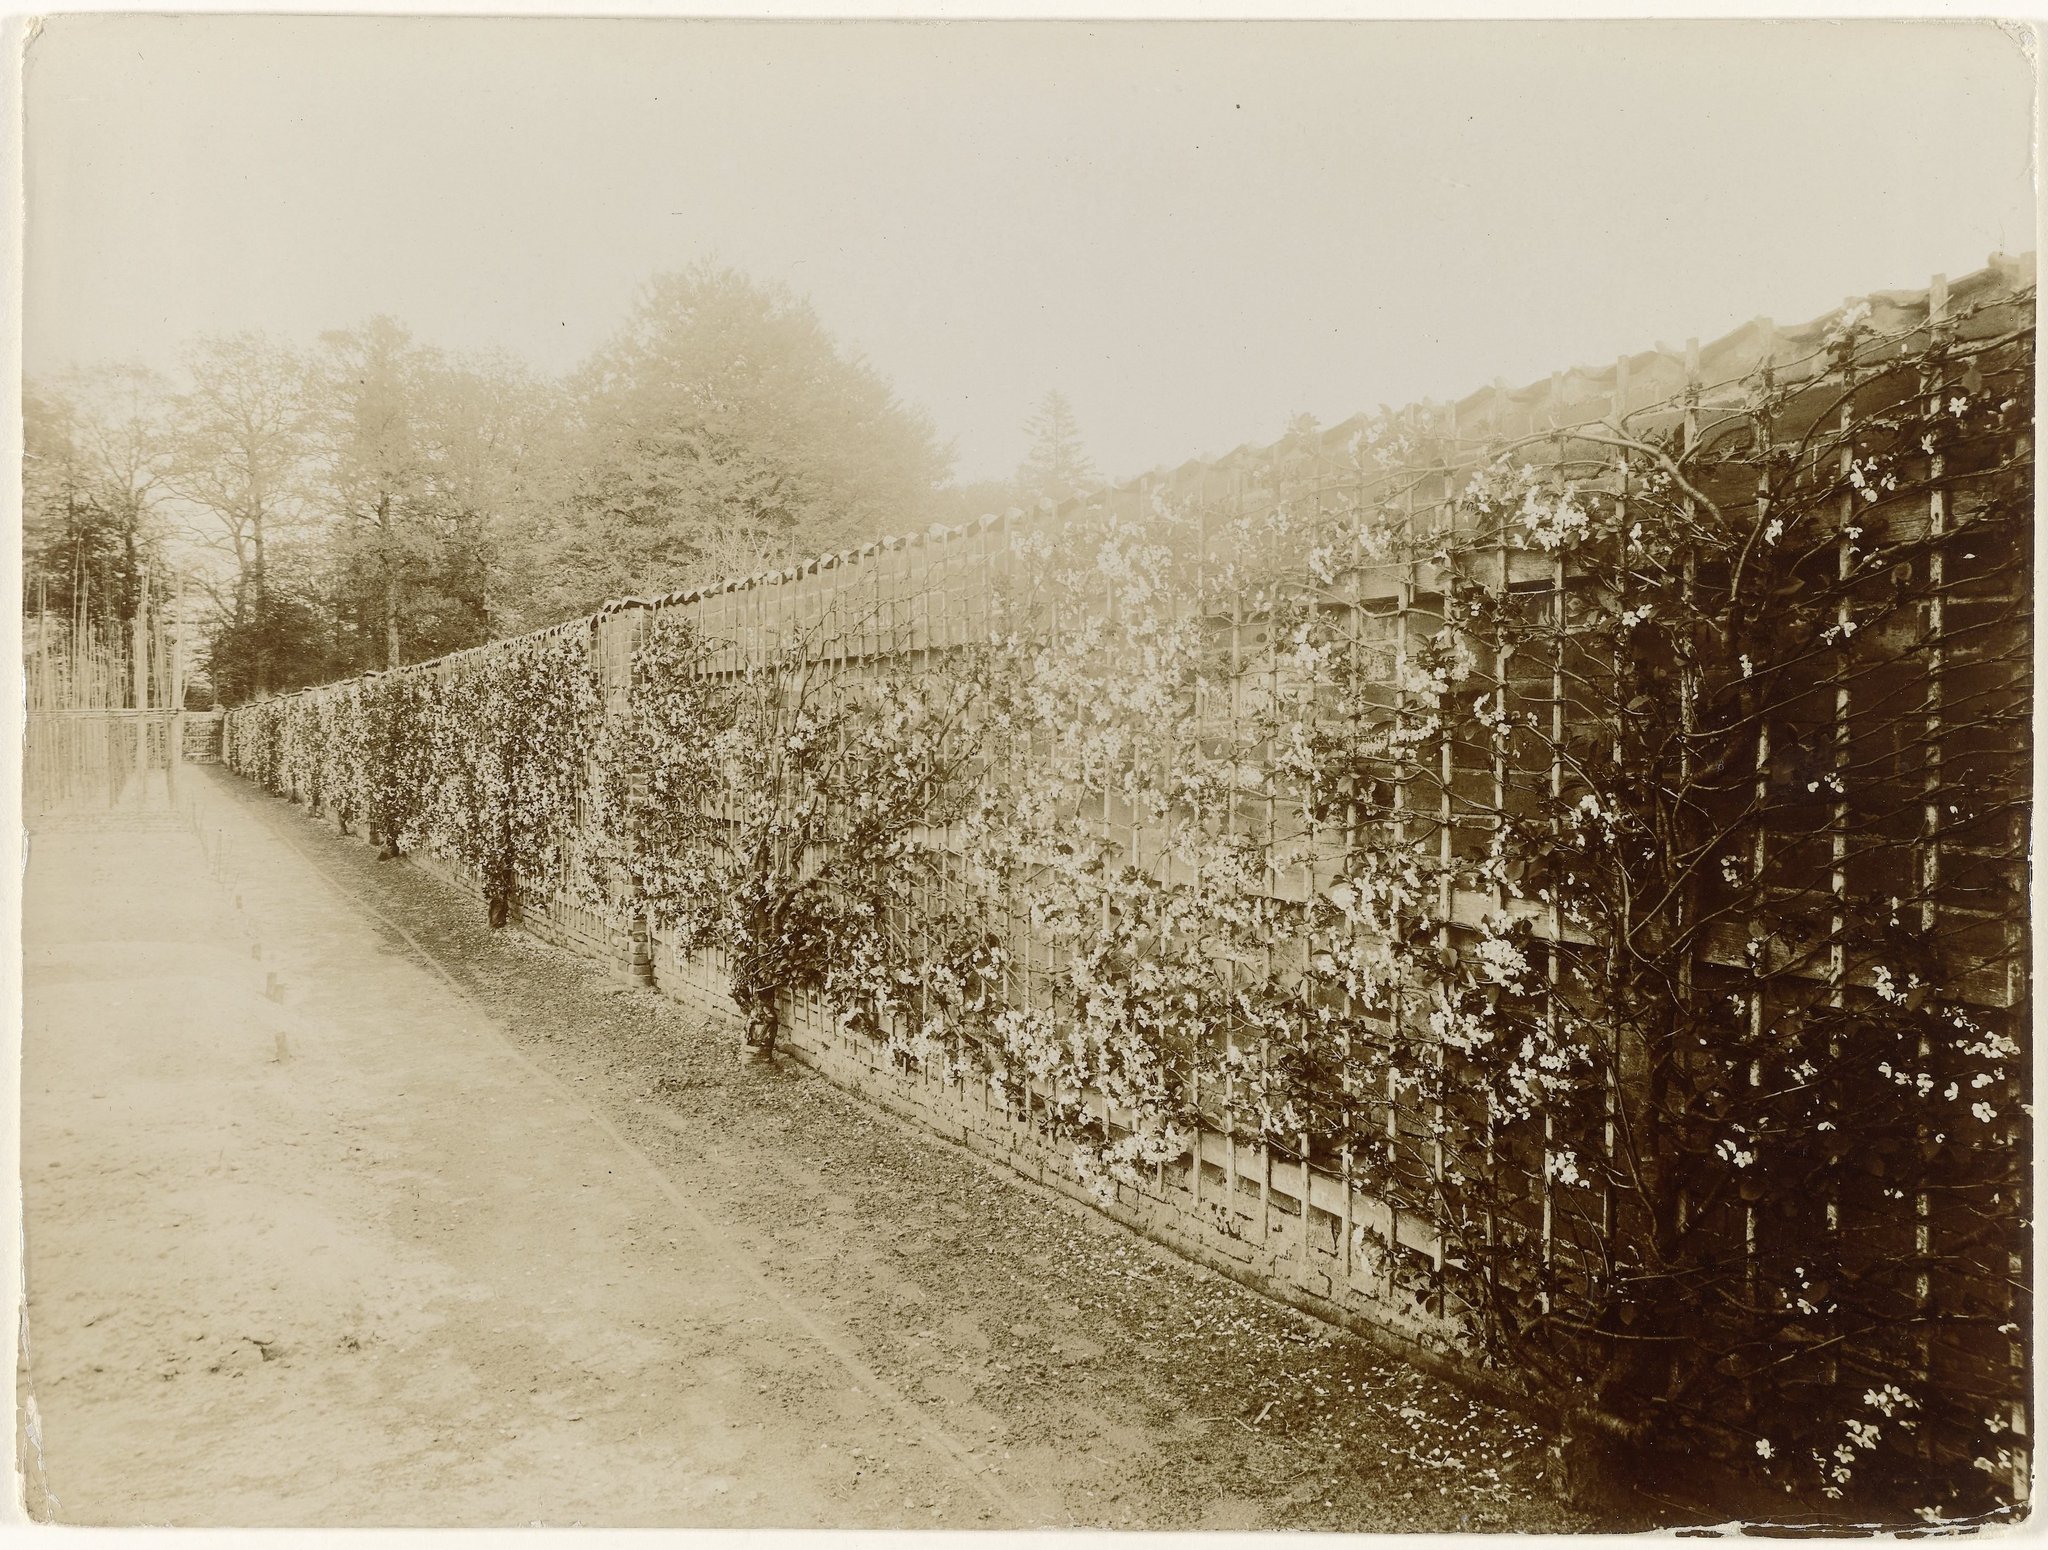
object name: photograph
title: Muur met morellen en heibomen in de moestuin van huize 'De Poll' te Voorst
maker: richard tepe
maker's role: fotograaf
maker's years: 1864-1952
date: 1900-1940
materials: photographic support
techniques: gelatin silver print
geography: netherlands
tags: ornamental plants, fruits: cherry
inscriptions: : ‘Muur met Morellen Leiboomen / in den Moestuin van den Huize "De Poll" / te Voorst (Gl’, signature: ‘foto / R Tepe’